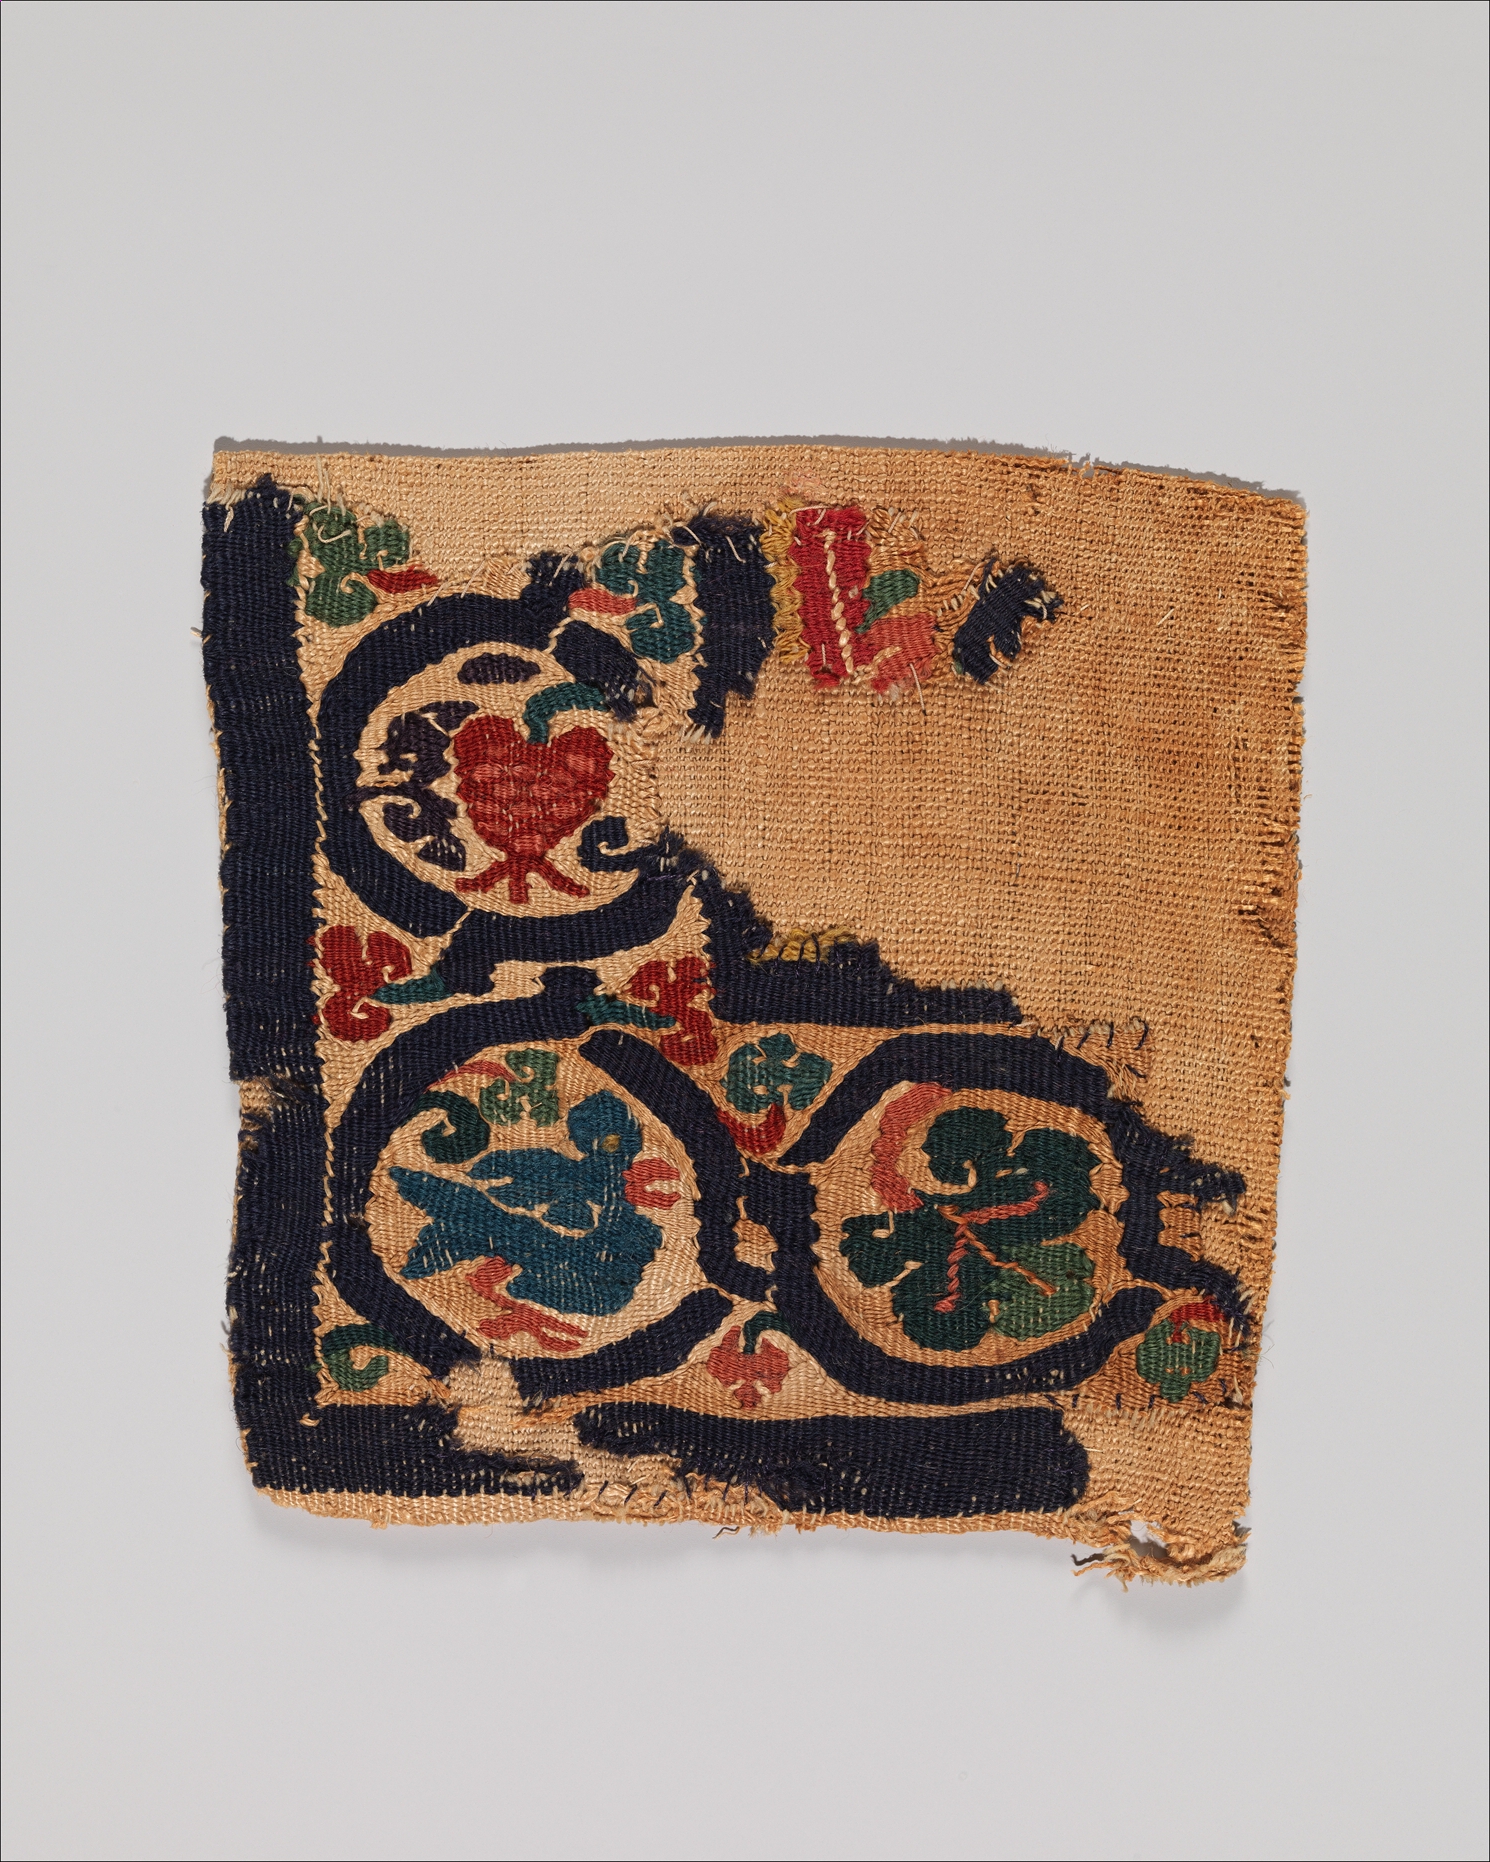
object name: textile fragment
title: Fragment of a Tabula (Square) with Birds and Pomegranates in a Vine Scroll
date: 401-700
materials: linen, wool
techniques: weave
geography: egypt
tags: birds